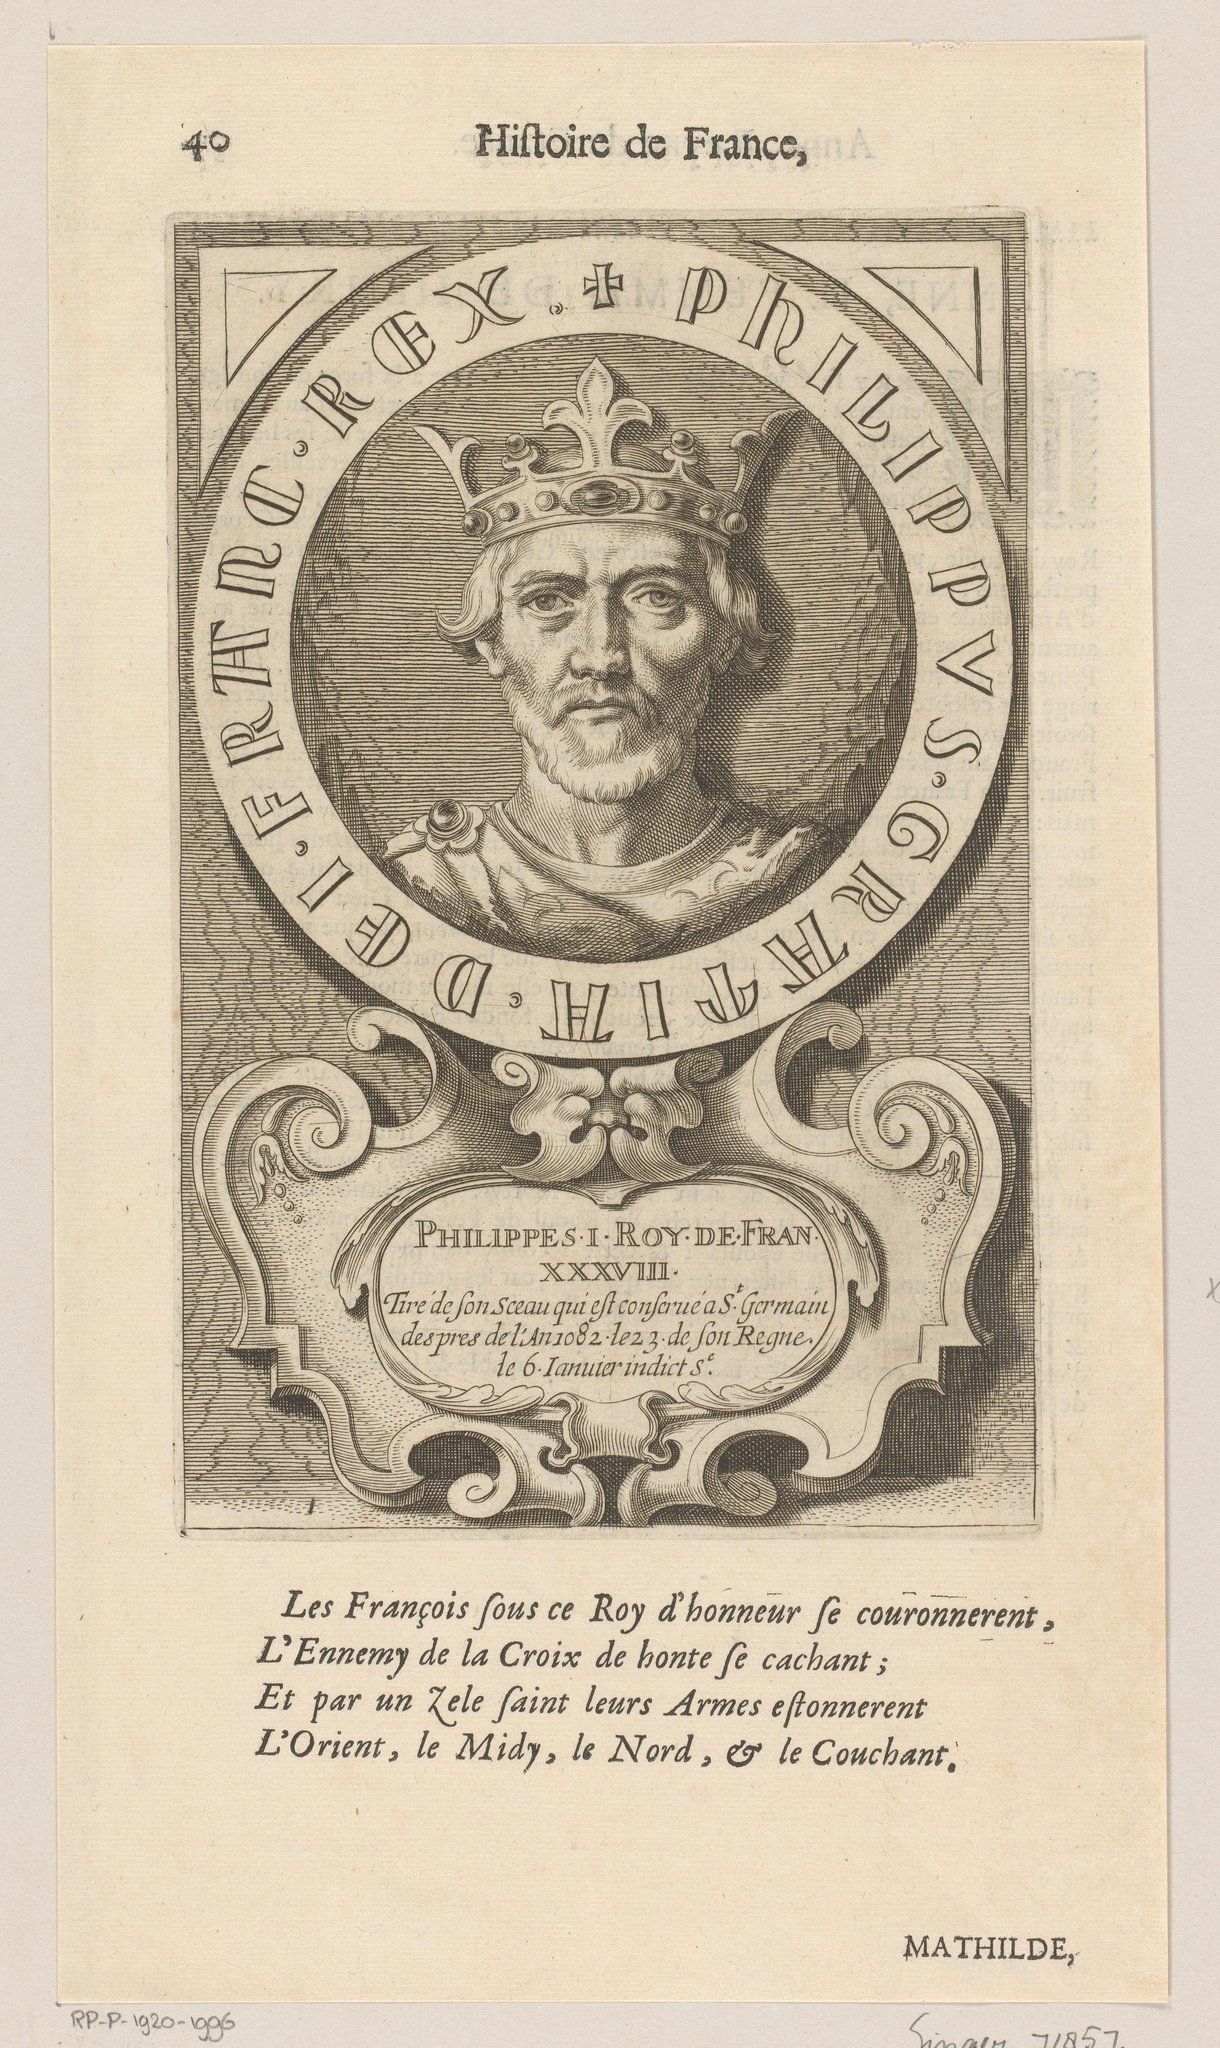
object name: book illustration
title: Phillippes I roy de Fran XXXVIII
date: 1635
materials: paper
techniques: engraving, letterpress printing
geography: paris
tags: historical persons, ruler, sovereign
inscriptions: collector's mark: Lugt 2228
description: Prent uit: Eudes de Mézeray, François. Histoire de France, depuis Faramond jusqu’au regne de Louis le Juste (...). 3 dln. Parijs: Denis Thierry, Jean Guignard en Claude Barbin, 1635, dl. 2. Prent waarschijnlijk voor het eerst verschenen in: Bie, Jacques de. Les vrais portraits des rois de France (...). Parijs: Jacques de Bie en Pierre Rocolet, 1634. Prent ook gebruikt in latere publicaties.